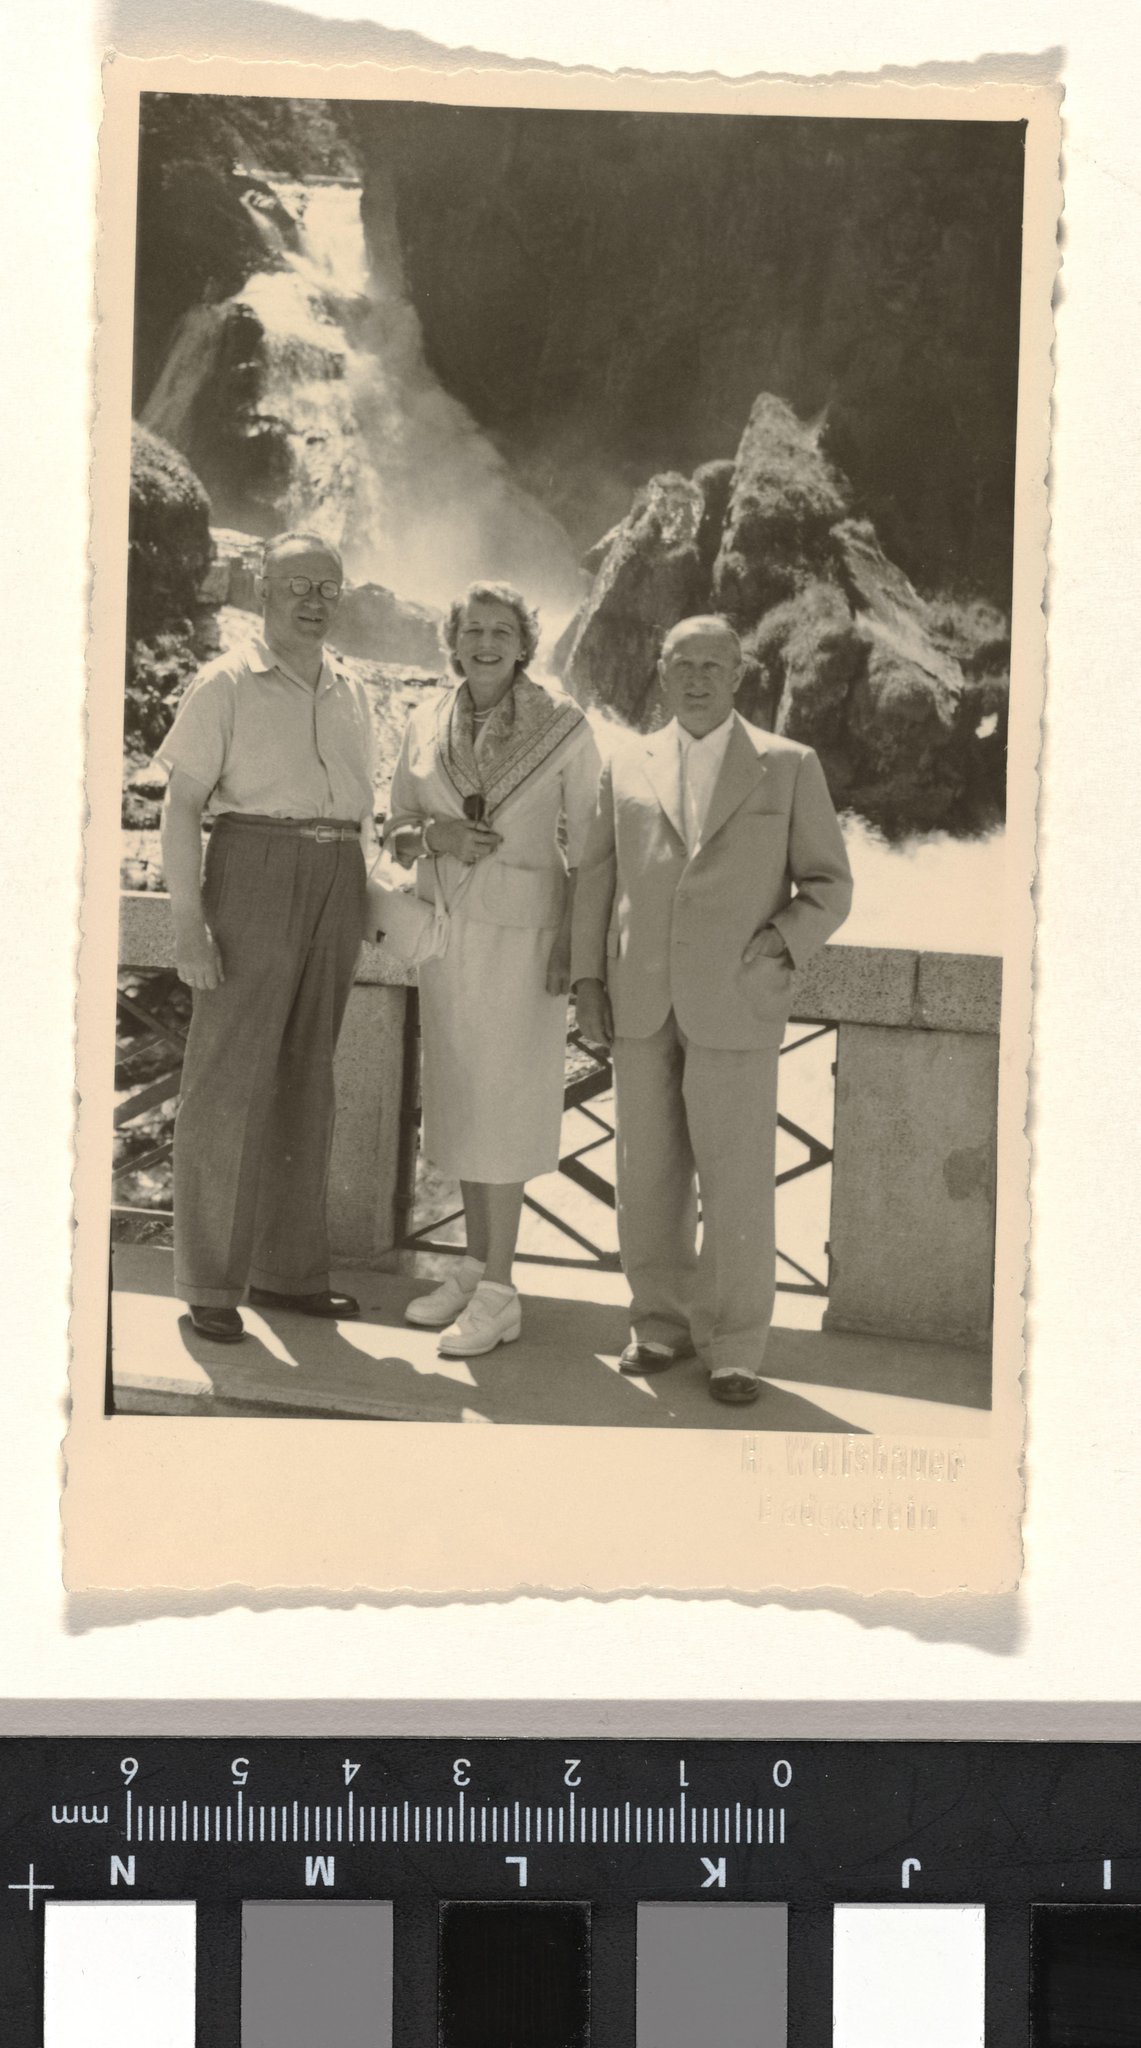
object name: photograph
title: Willy Moos met twee onbekende mensen, staand voor een reling bij een waterval met rotsen bij Bad Gastein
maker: Anonymous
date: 1952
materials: photographic support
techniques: gelatin silver print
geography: bad gastein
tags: willy moos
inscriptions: date: ‘Bad Gastein 18/8/52’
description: Willy Moos (rechts) in licht pak met twee onbekende mensen, staand voor een reling bij een waterval met rotsen.